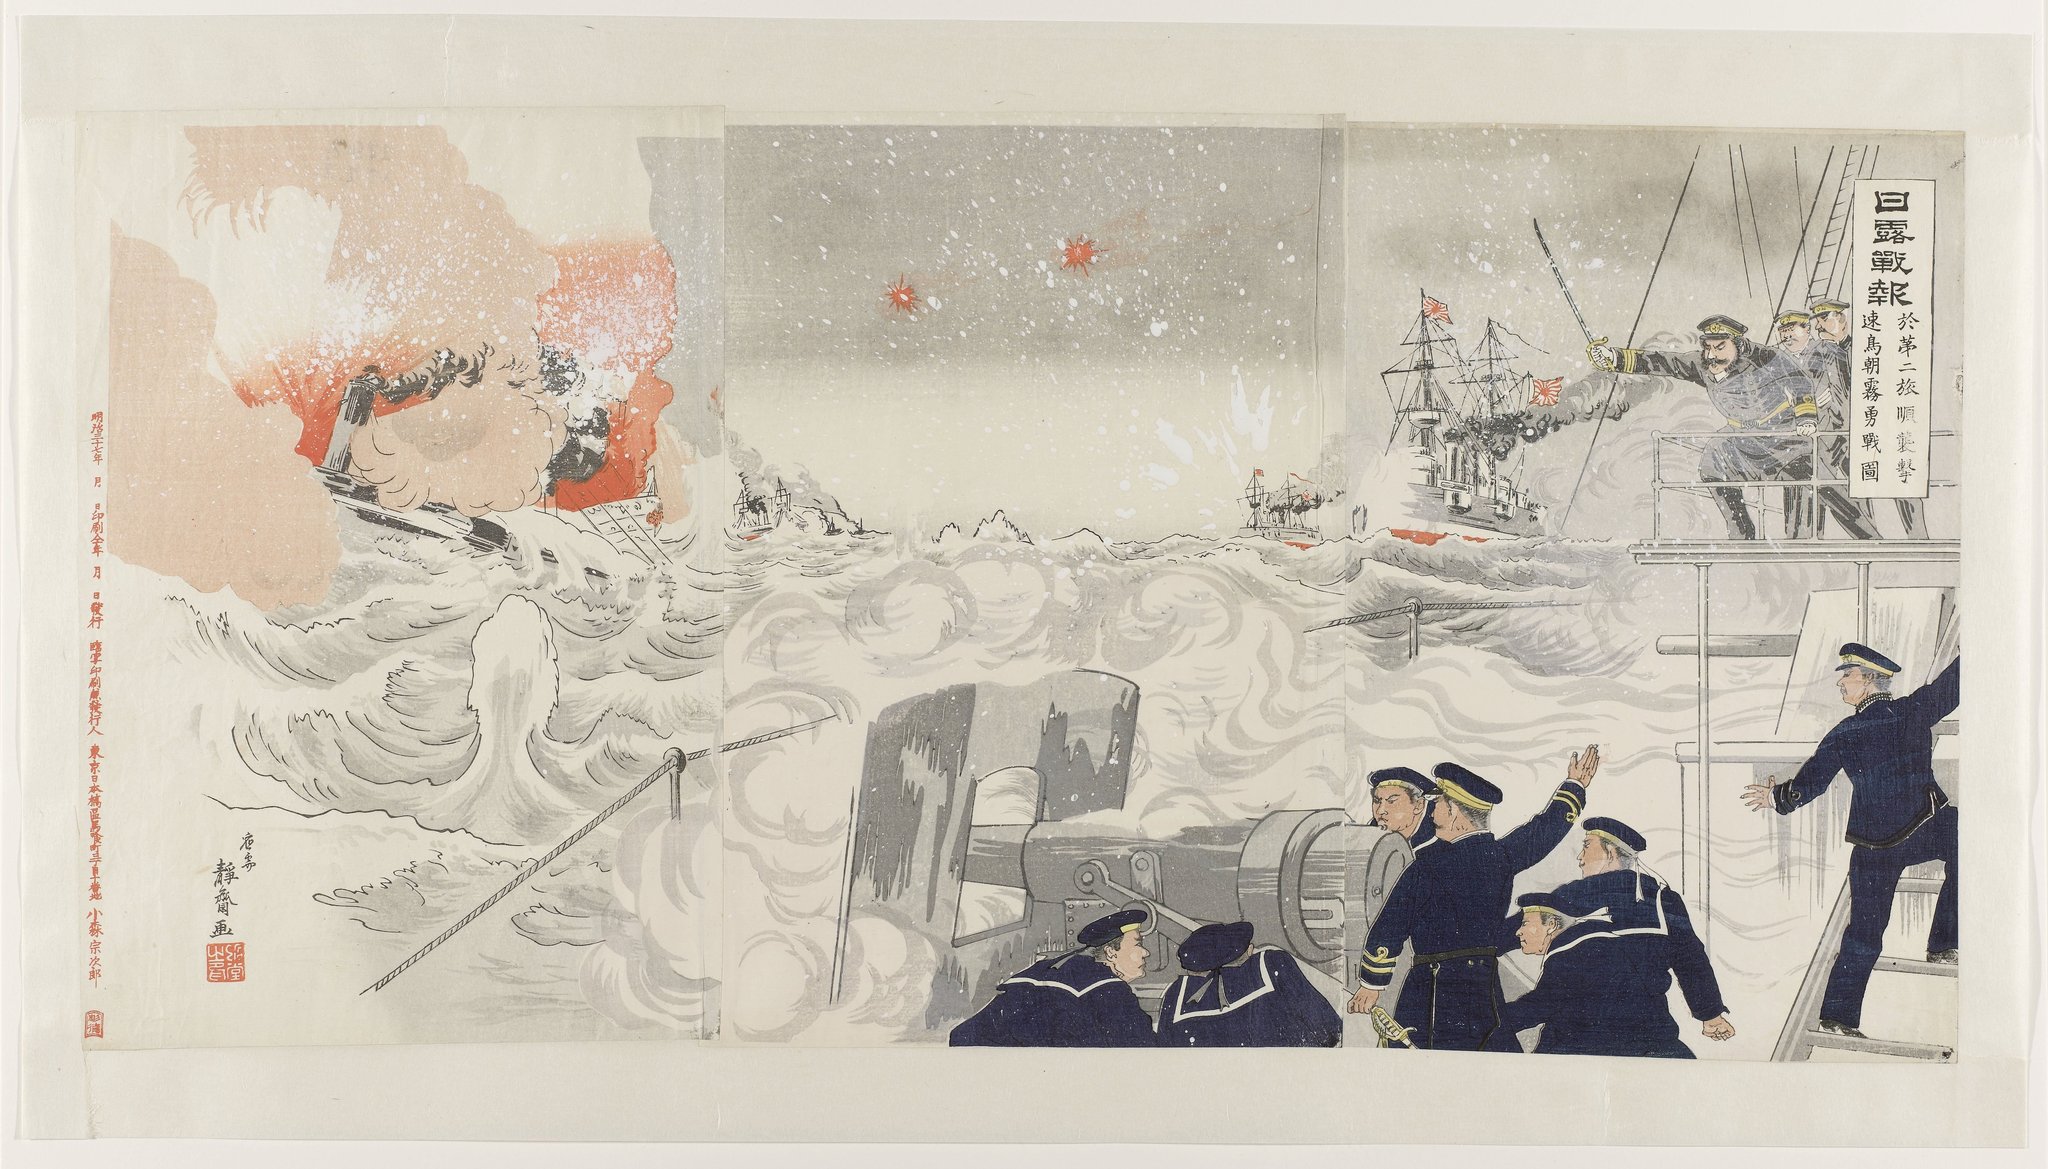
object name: print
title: Yori dai ni Ryojun shôgeki Hayatori asagiri yûsen zu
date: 1904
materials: paper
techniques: woodcut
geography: japan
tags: sinking (movement in water), battle (+ naval force), firearms: cannon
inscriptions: collector's mark: Lugt 2228, number: ‘1797 N: 1 i’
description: De twee Japanse oorlogsschepen brengen Russische schepen tot zinken. Dit was de tweede aanval van Japan op de Russische vloot in de Gele Zee en vond plaats op 11 februari 1904, tijdens de Russisch-Japanse Oorlog (1904-1905).